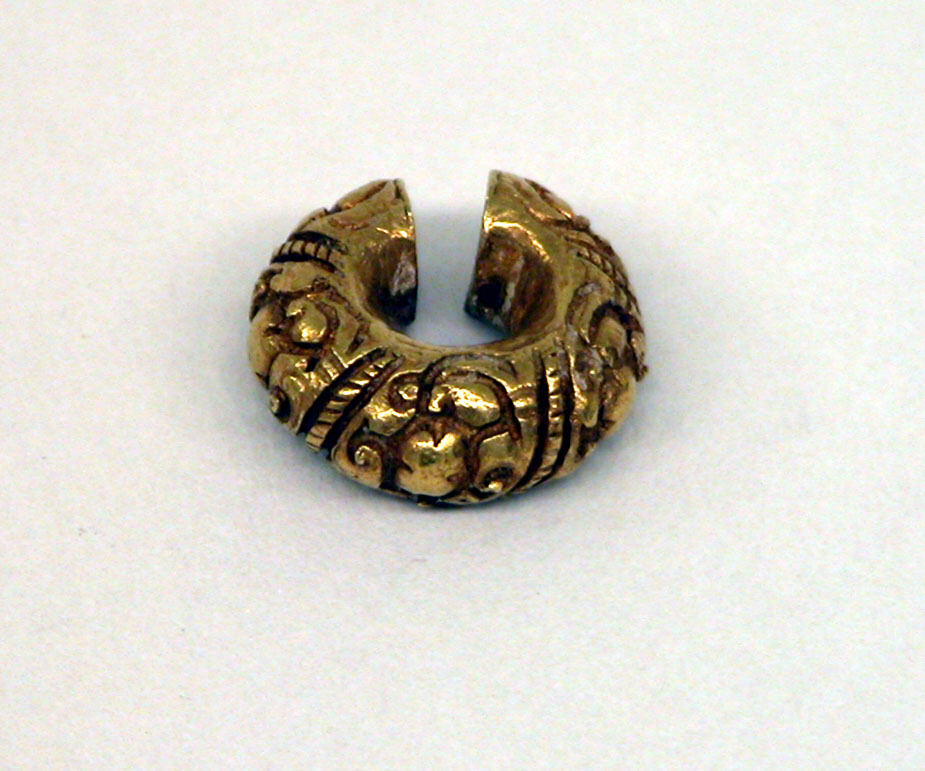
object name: ear ornament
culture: indonesian, javanese